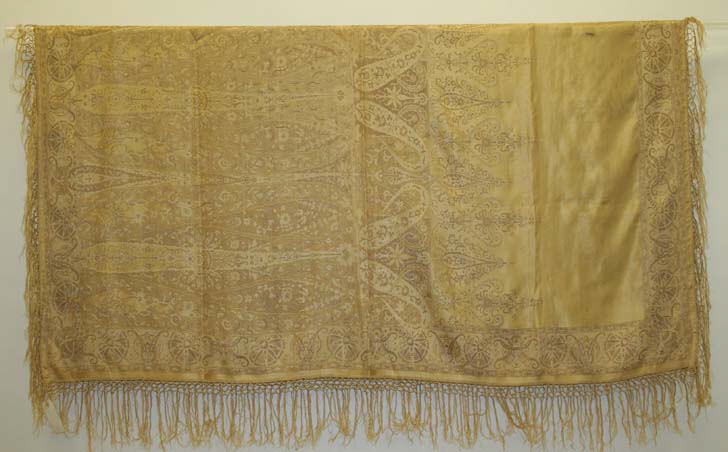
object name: shawl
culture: french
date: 1801-1900